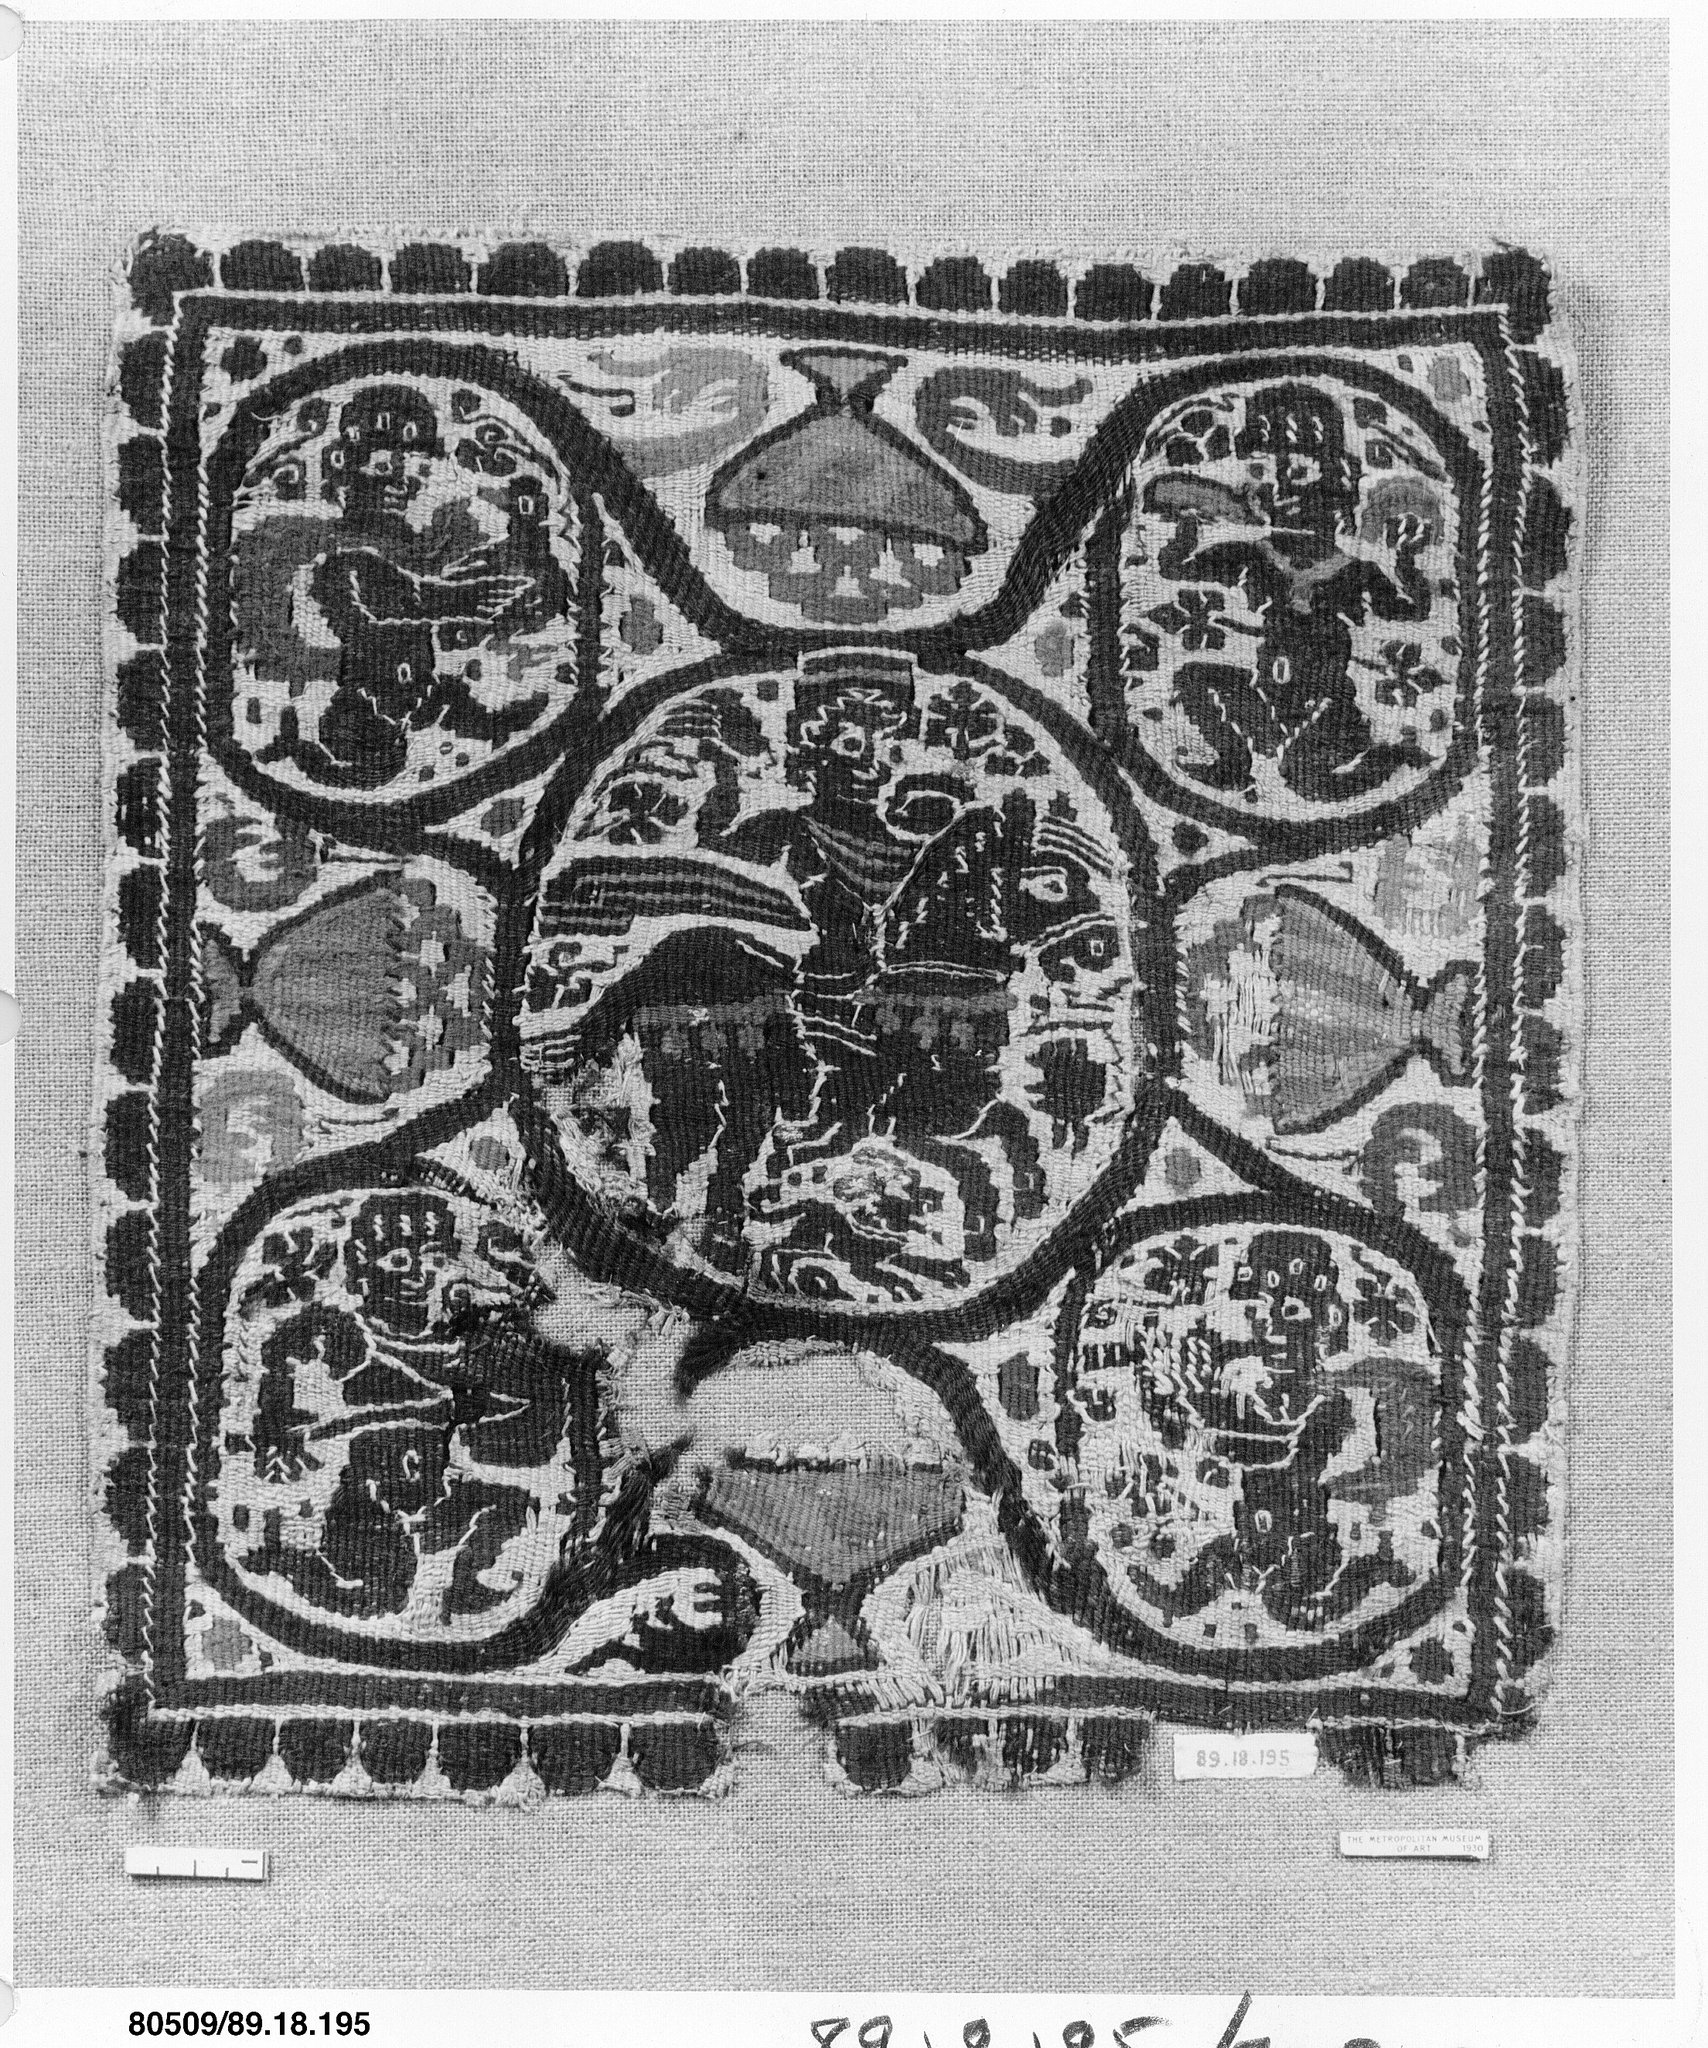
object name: textile fragment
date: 301-400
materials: linen, wool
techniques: weave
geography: egypt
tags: human figures,horses